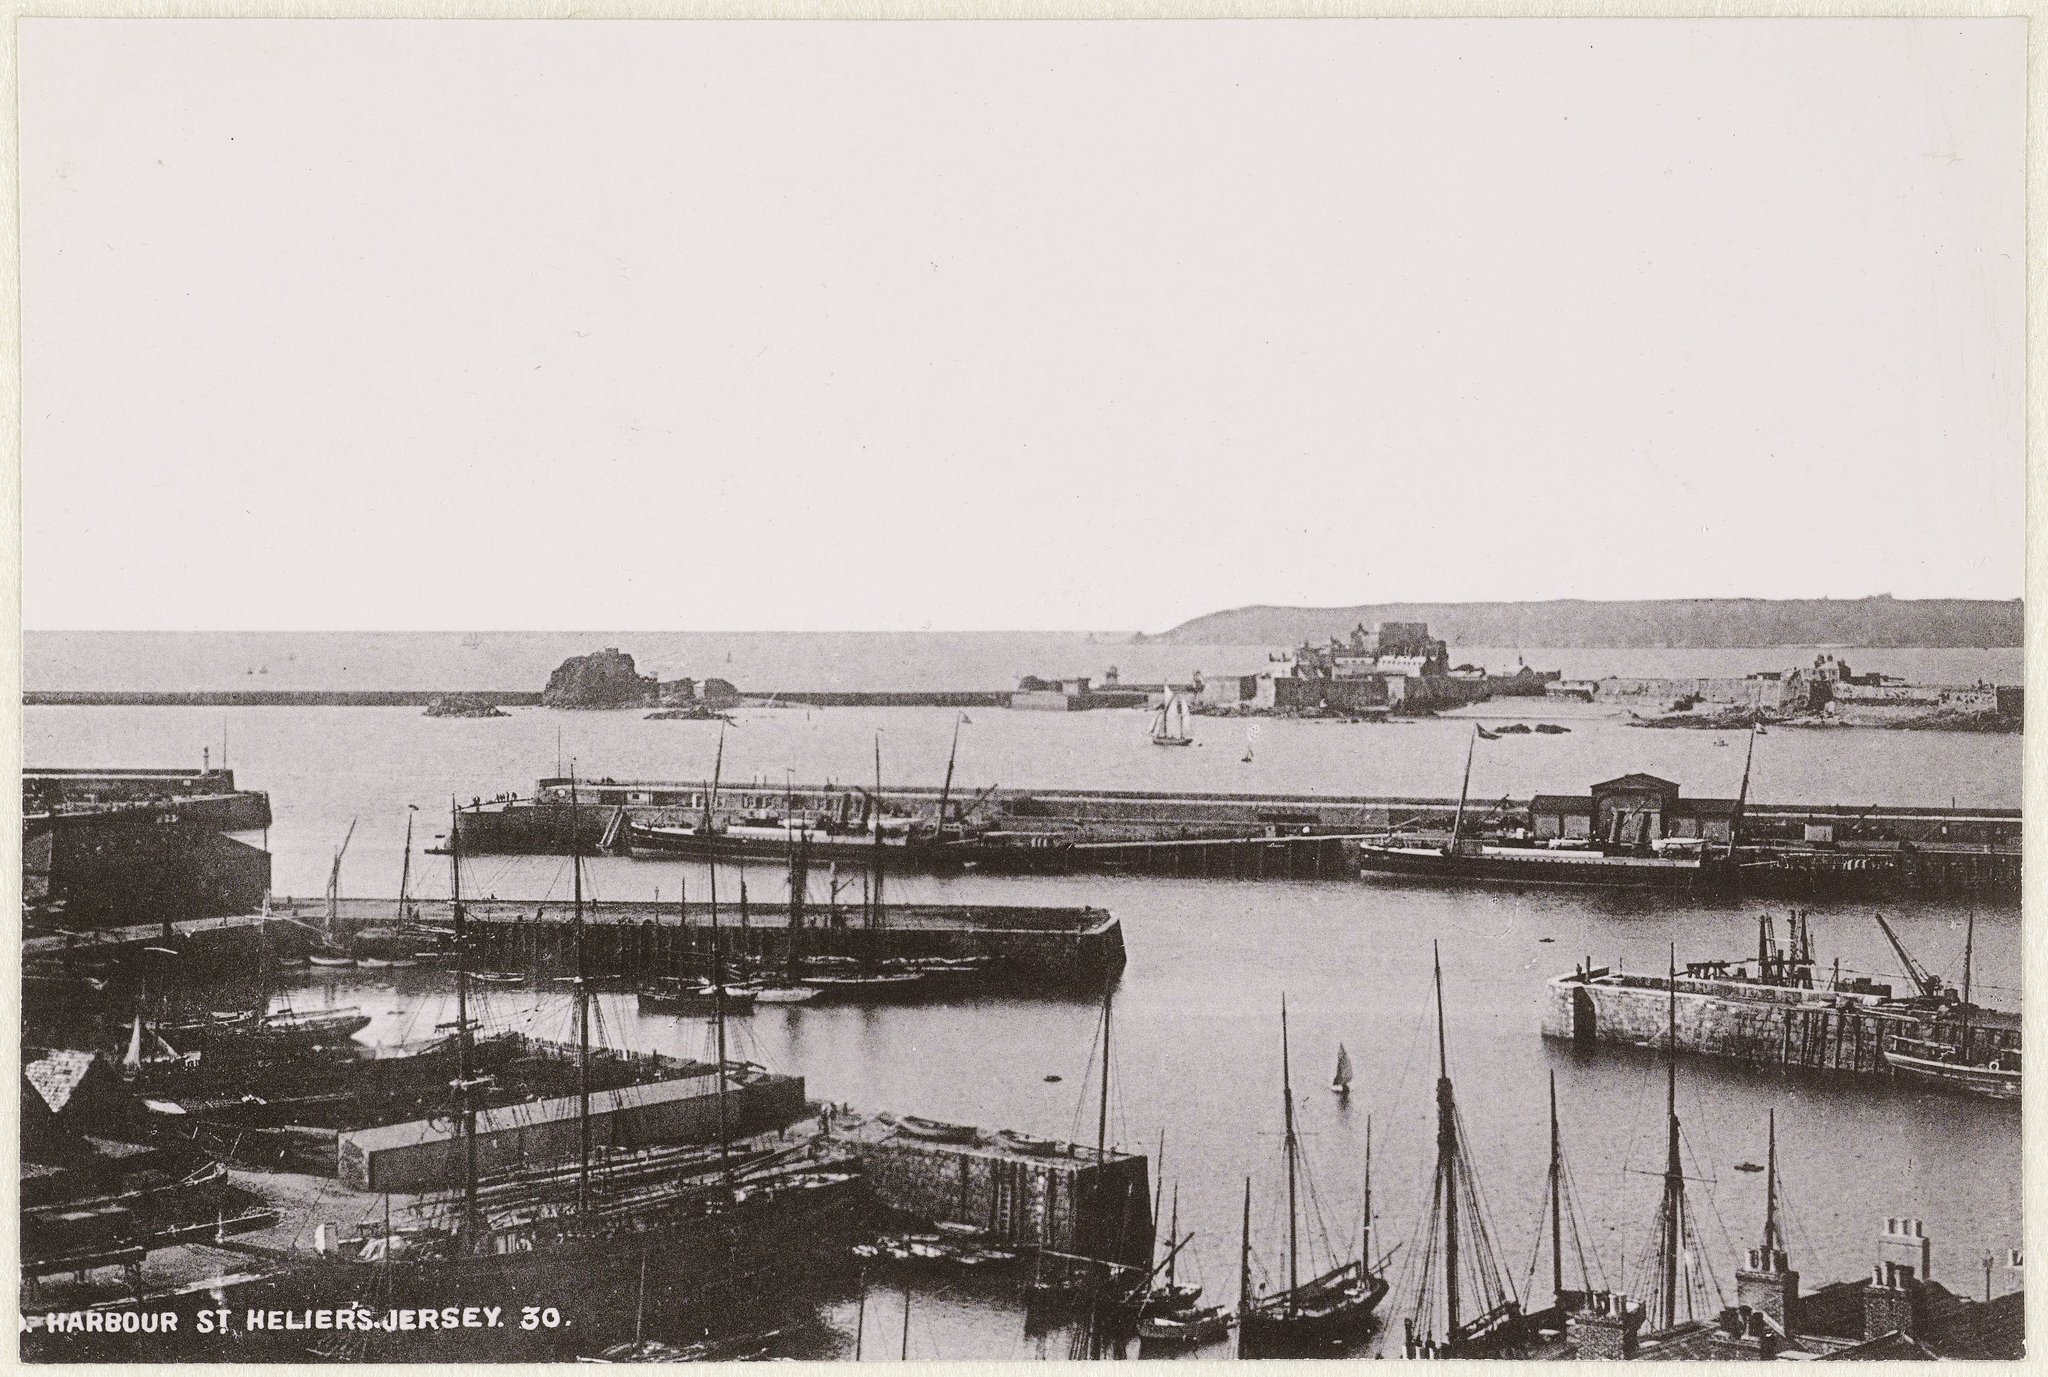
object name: photomechanical print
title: Harbour St Helier's, Jersey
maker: Anonymous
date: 1870-1930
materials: paper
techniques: photograph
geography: jersey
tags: harbour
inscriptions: number: ‘30’